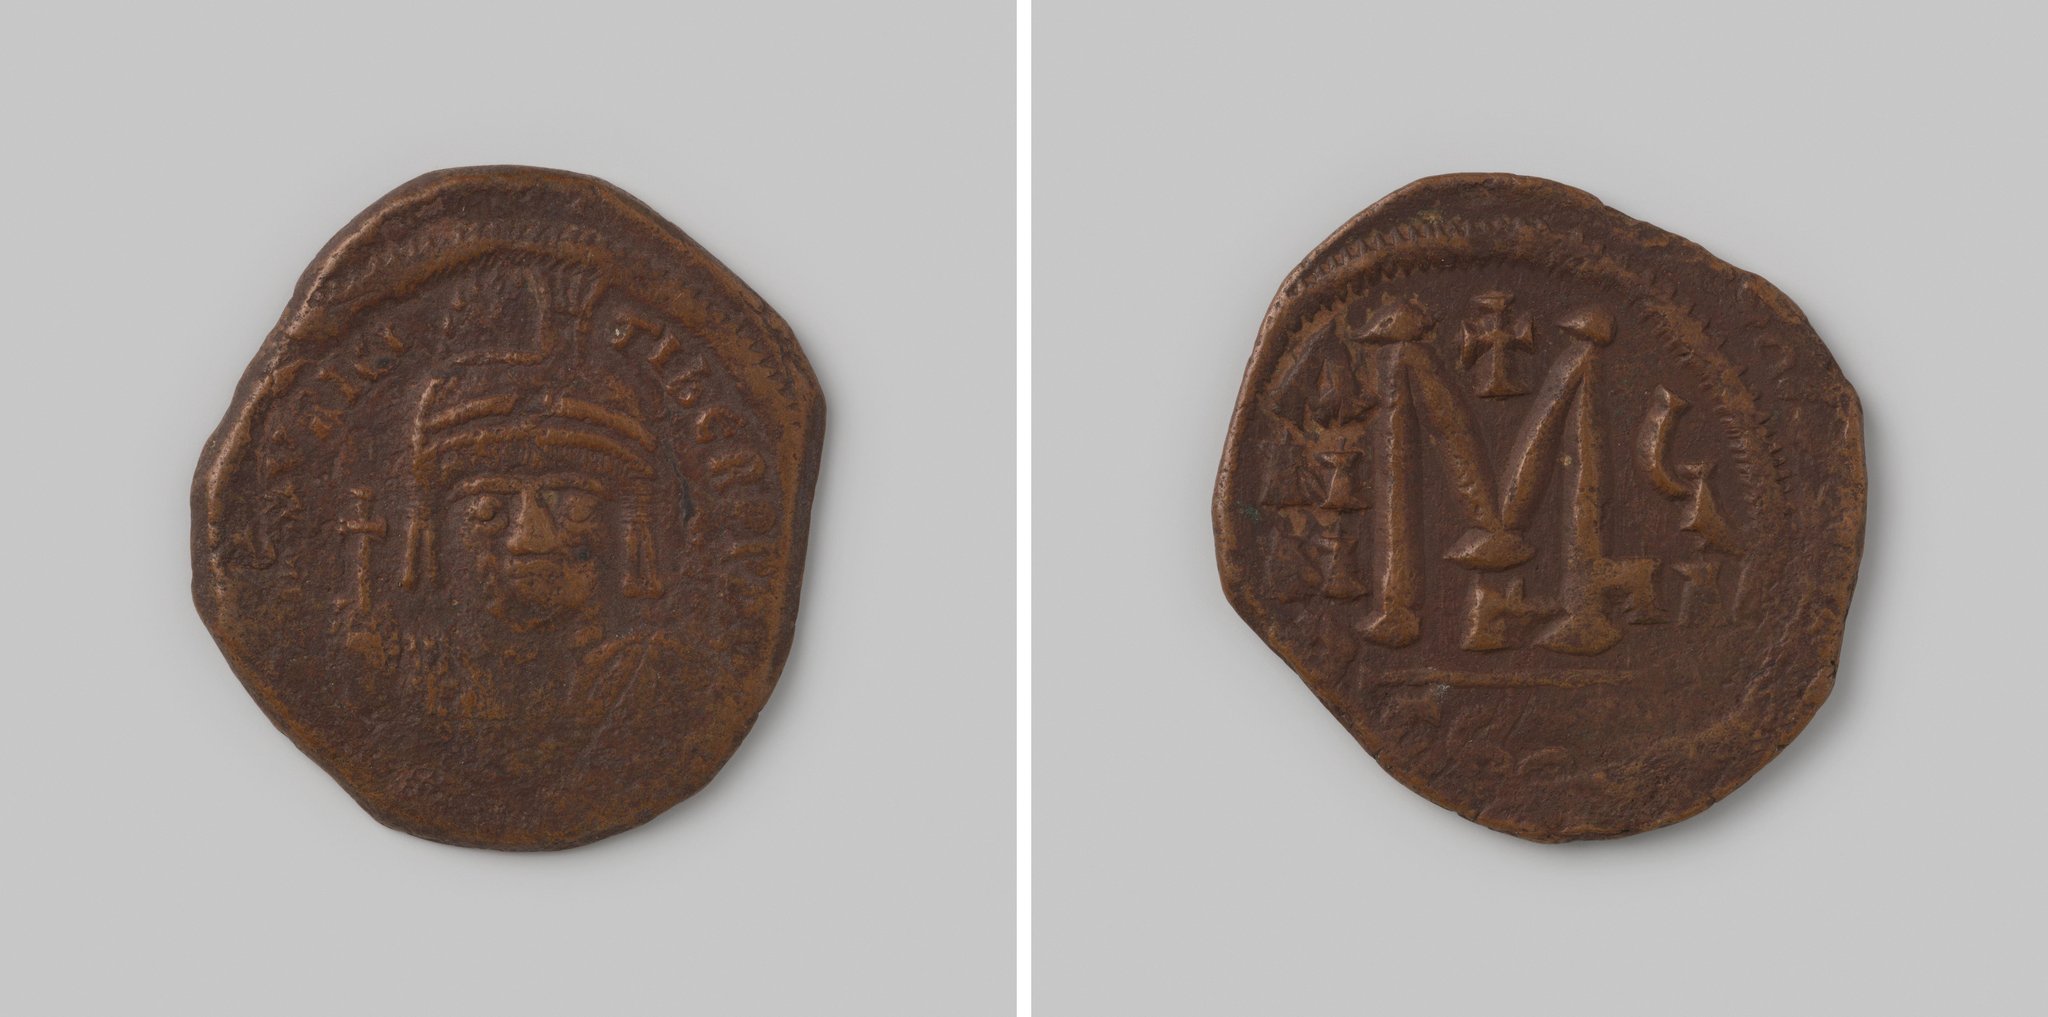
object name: coin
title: Follis uit het Byzantijnse Keizerrijk van Flavius Tiberius Mauritius, 582-602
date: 586-602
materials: bronze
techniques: striking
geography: constantinople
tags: keizer, flavius mauritius tiberius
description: keerzijde: tussen jaar-aanduiding Anno VI letter M [=40, waarde-aanduiding, 40 nummia] met boven de letter een kruis. In de afsnede de letters CO..[=Constantinopel]